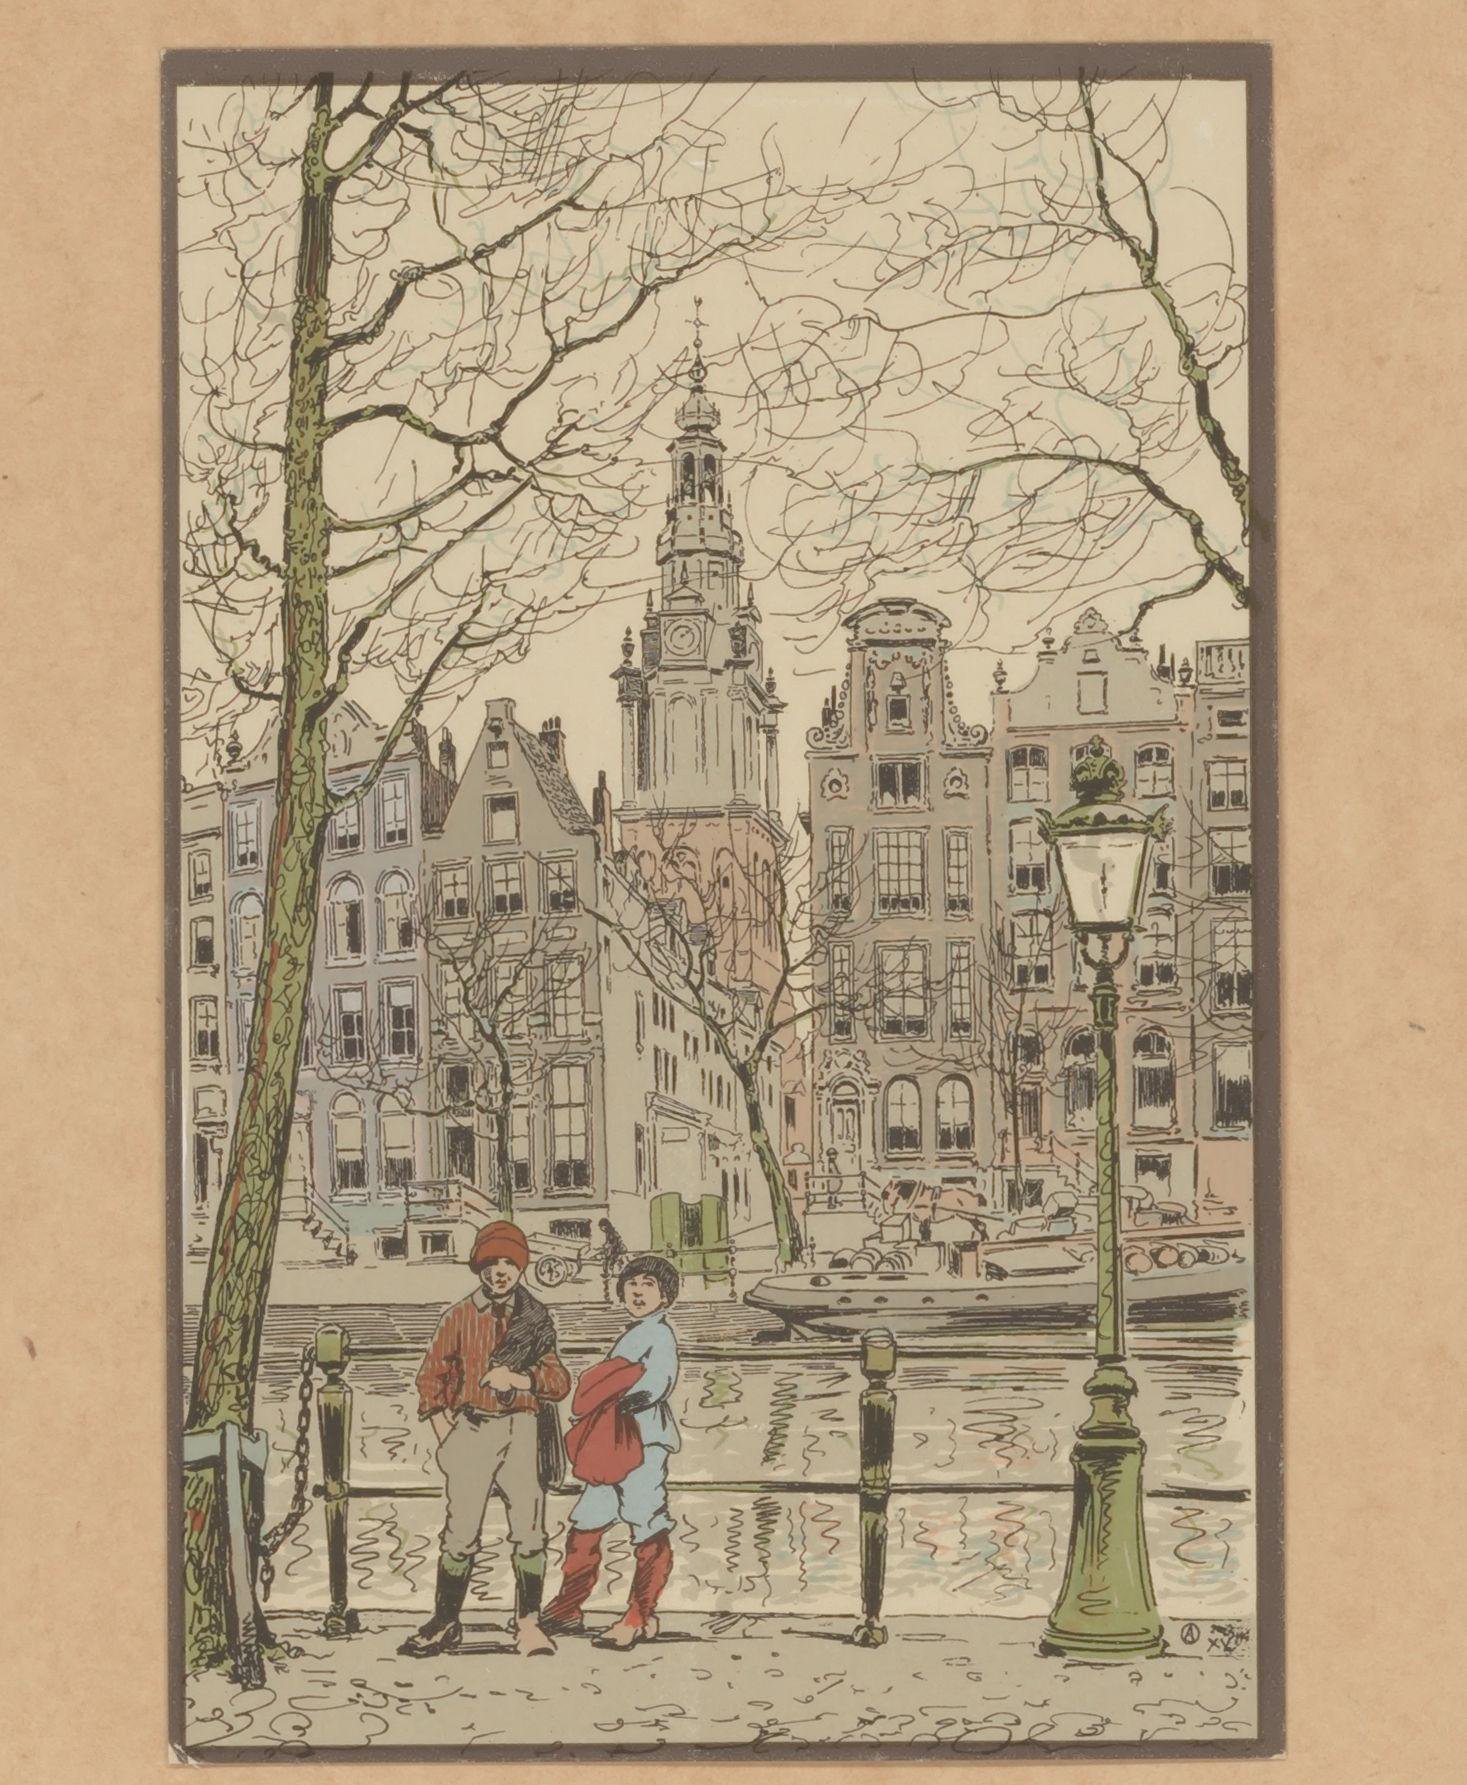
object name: photomechanical print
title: Gezicht op de Kloveniersburgwal met de Zuiderkerkstoren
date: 1915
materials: cardboard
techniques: line block, printing block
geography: utrecht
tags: tower, clock tower ~ monumental adornment, city-view in general; 'veduta', canal, church (exterior)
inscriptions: signature: ‘A’, collector's mark: ‘3-46’ Lugt 1641b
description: Onderwerpsrubriek binnen de Atlas Amsterdam: Panorama's en verzamelprenten.